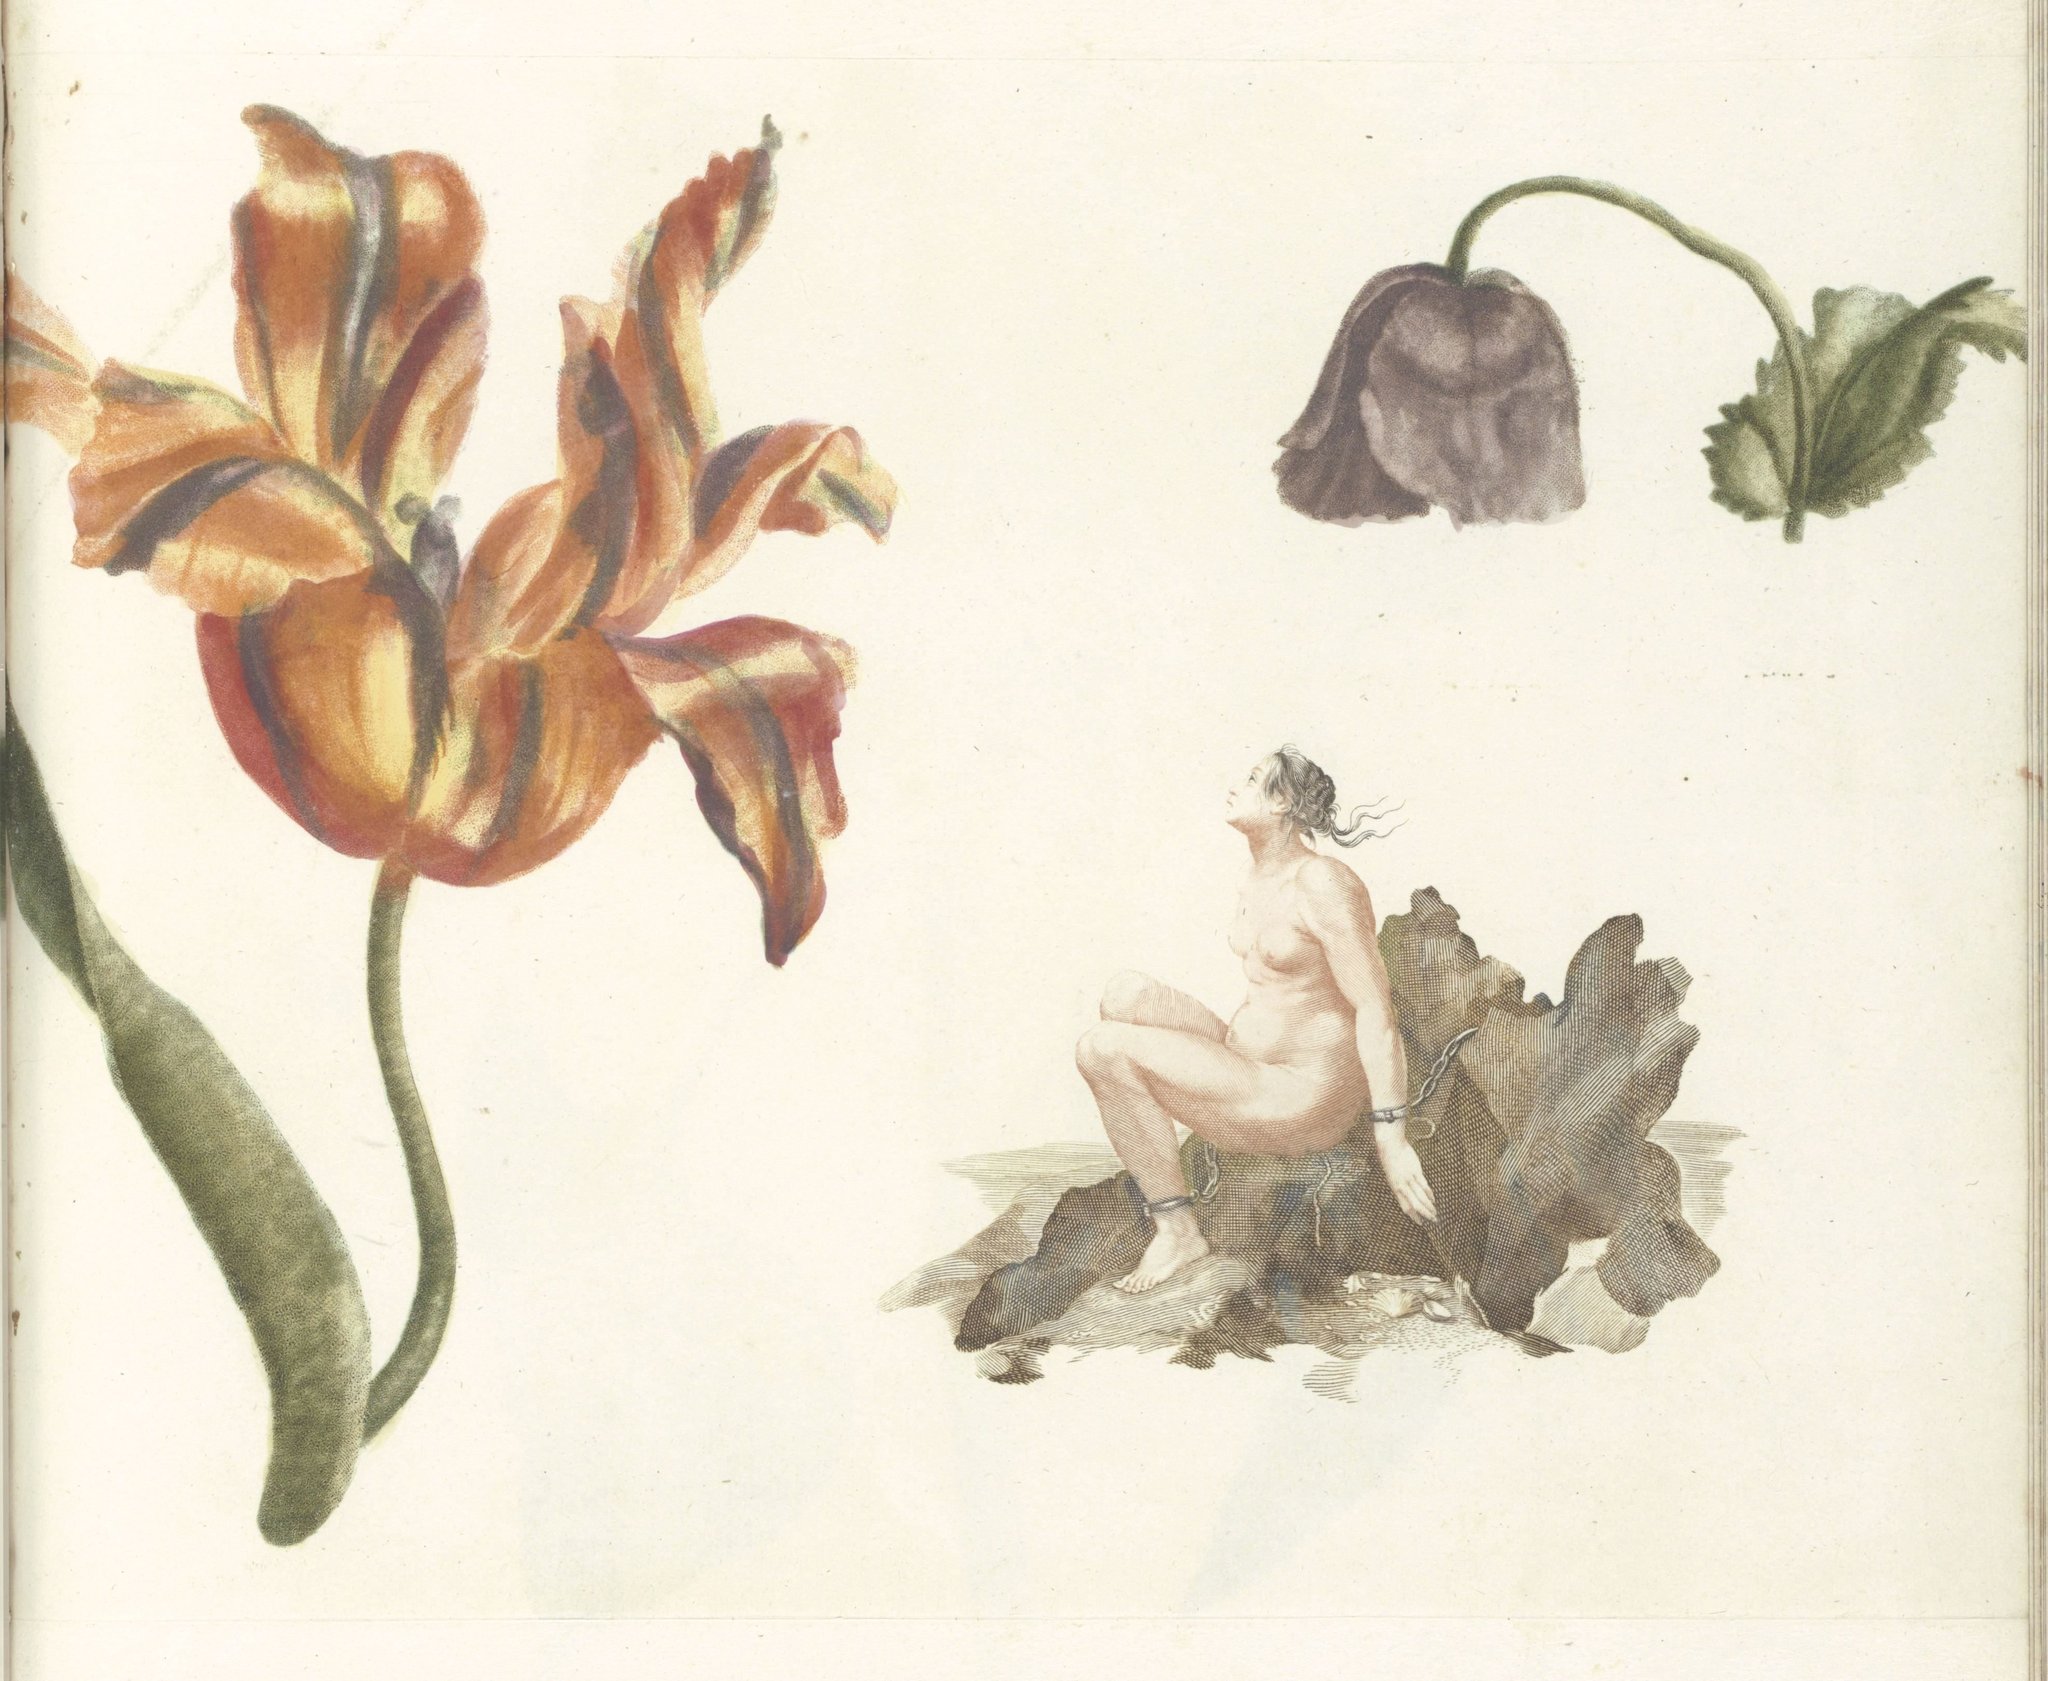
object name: album leaf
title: Tulp, papaver en Andromeda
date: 1688-1698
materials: paper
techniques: printing, drypoint, engraving, hand coloring, roulette, lithography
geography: netherlands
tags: andromeda chained to the rock, flowers: tulip, flowers: poppy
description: Drie voorstellingen. Een tulp en een papaver. Andromeda geketend aan de rots, naast haar enkele schelpen. Deze prent maakt deel uit van een album.